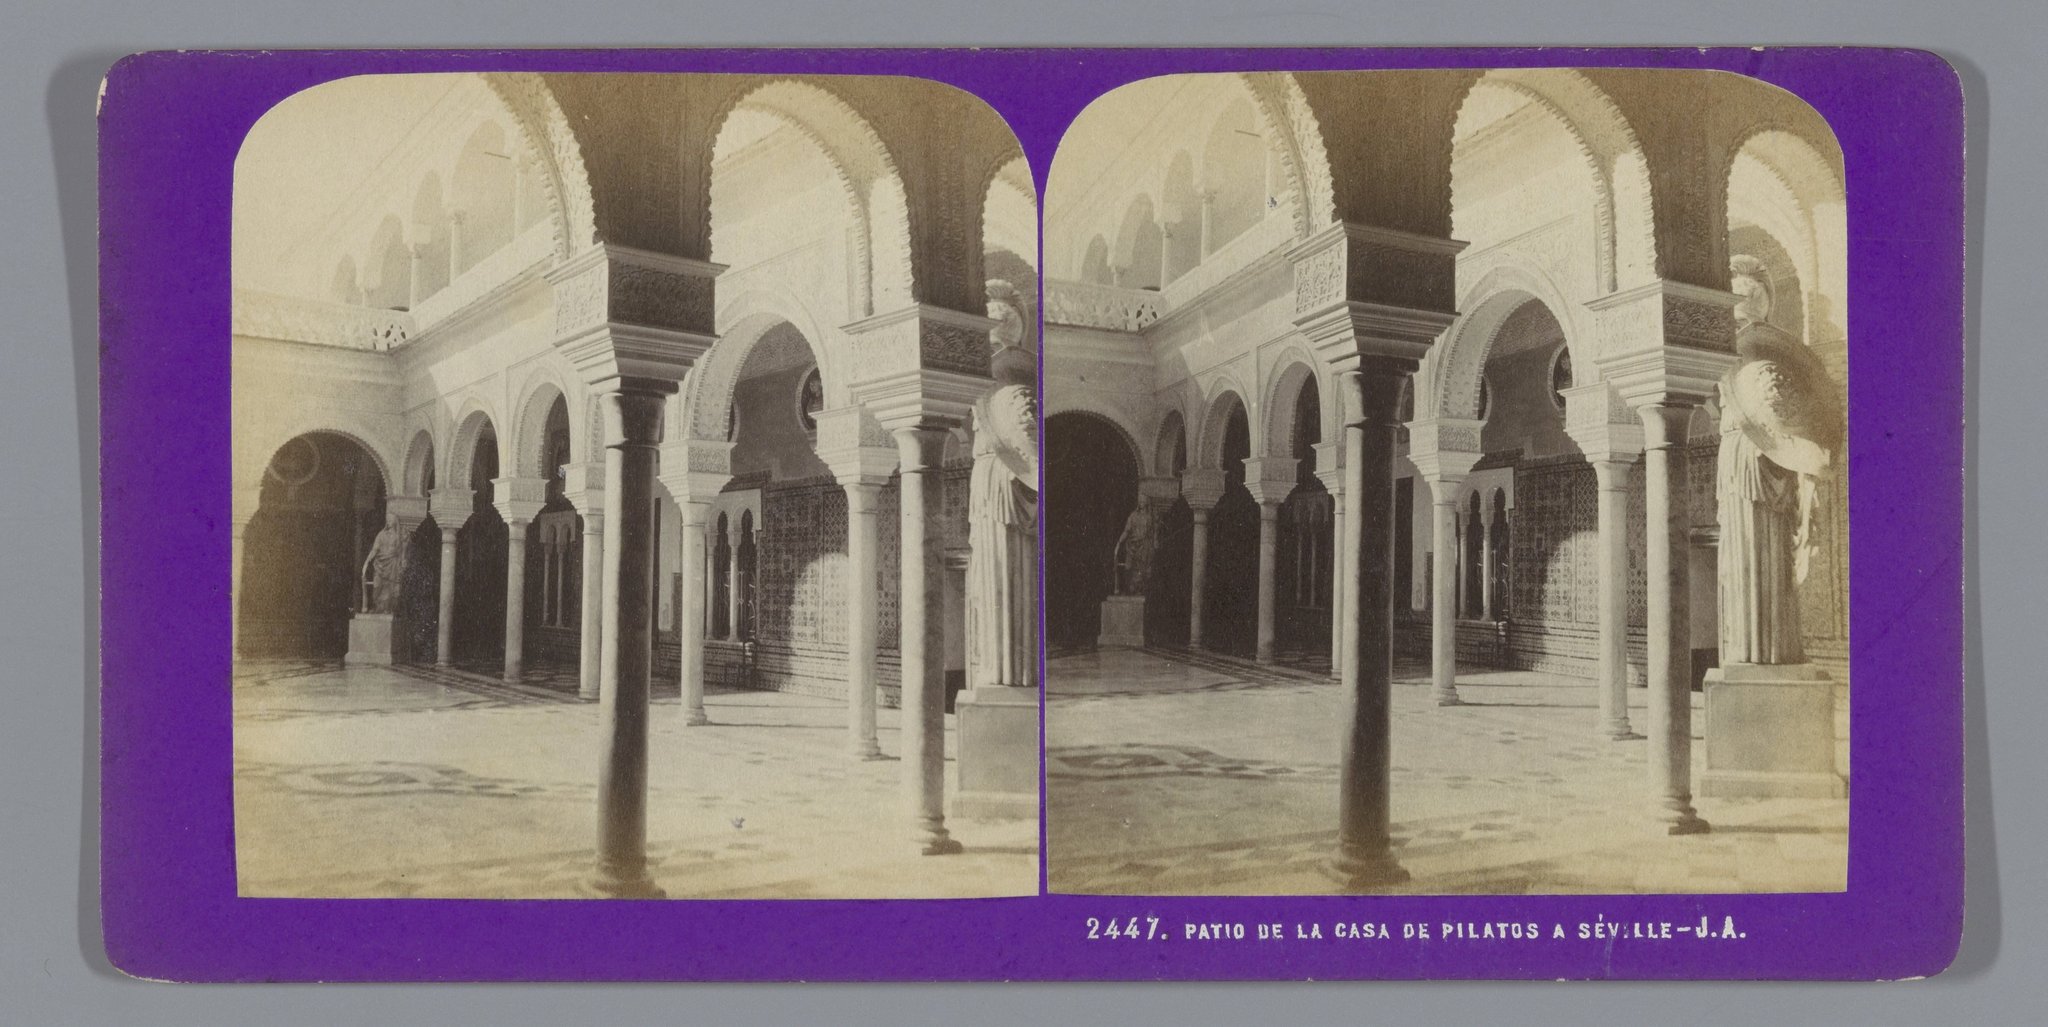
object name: stereograph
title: Gezicht op de binnenplaats van het Casa de Pilatos in Sevilla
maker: jean andrieu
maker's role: fotograaf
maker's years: 1816-1872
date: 1862-1876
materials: cardboard, photographic support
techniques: albumen print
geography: casa de pilatos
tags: arch, archivolt ~ architecture, courtyard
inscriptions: number: ‘2447.’